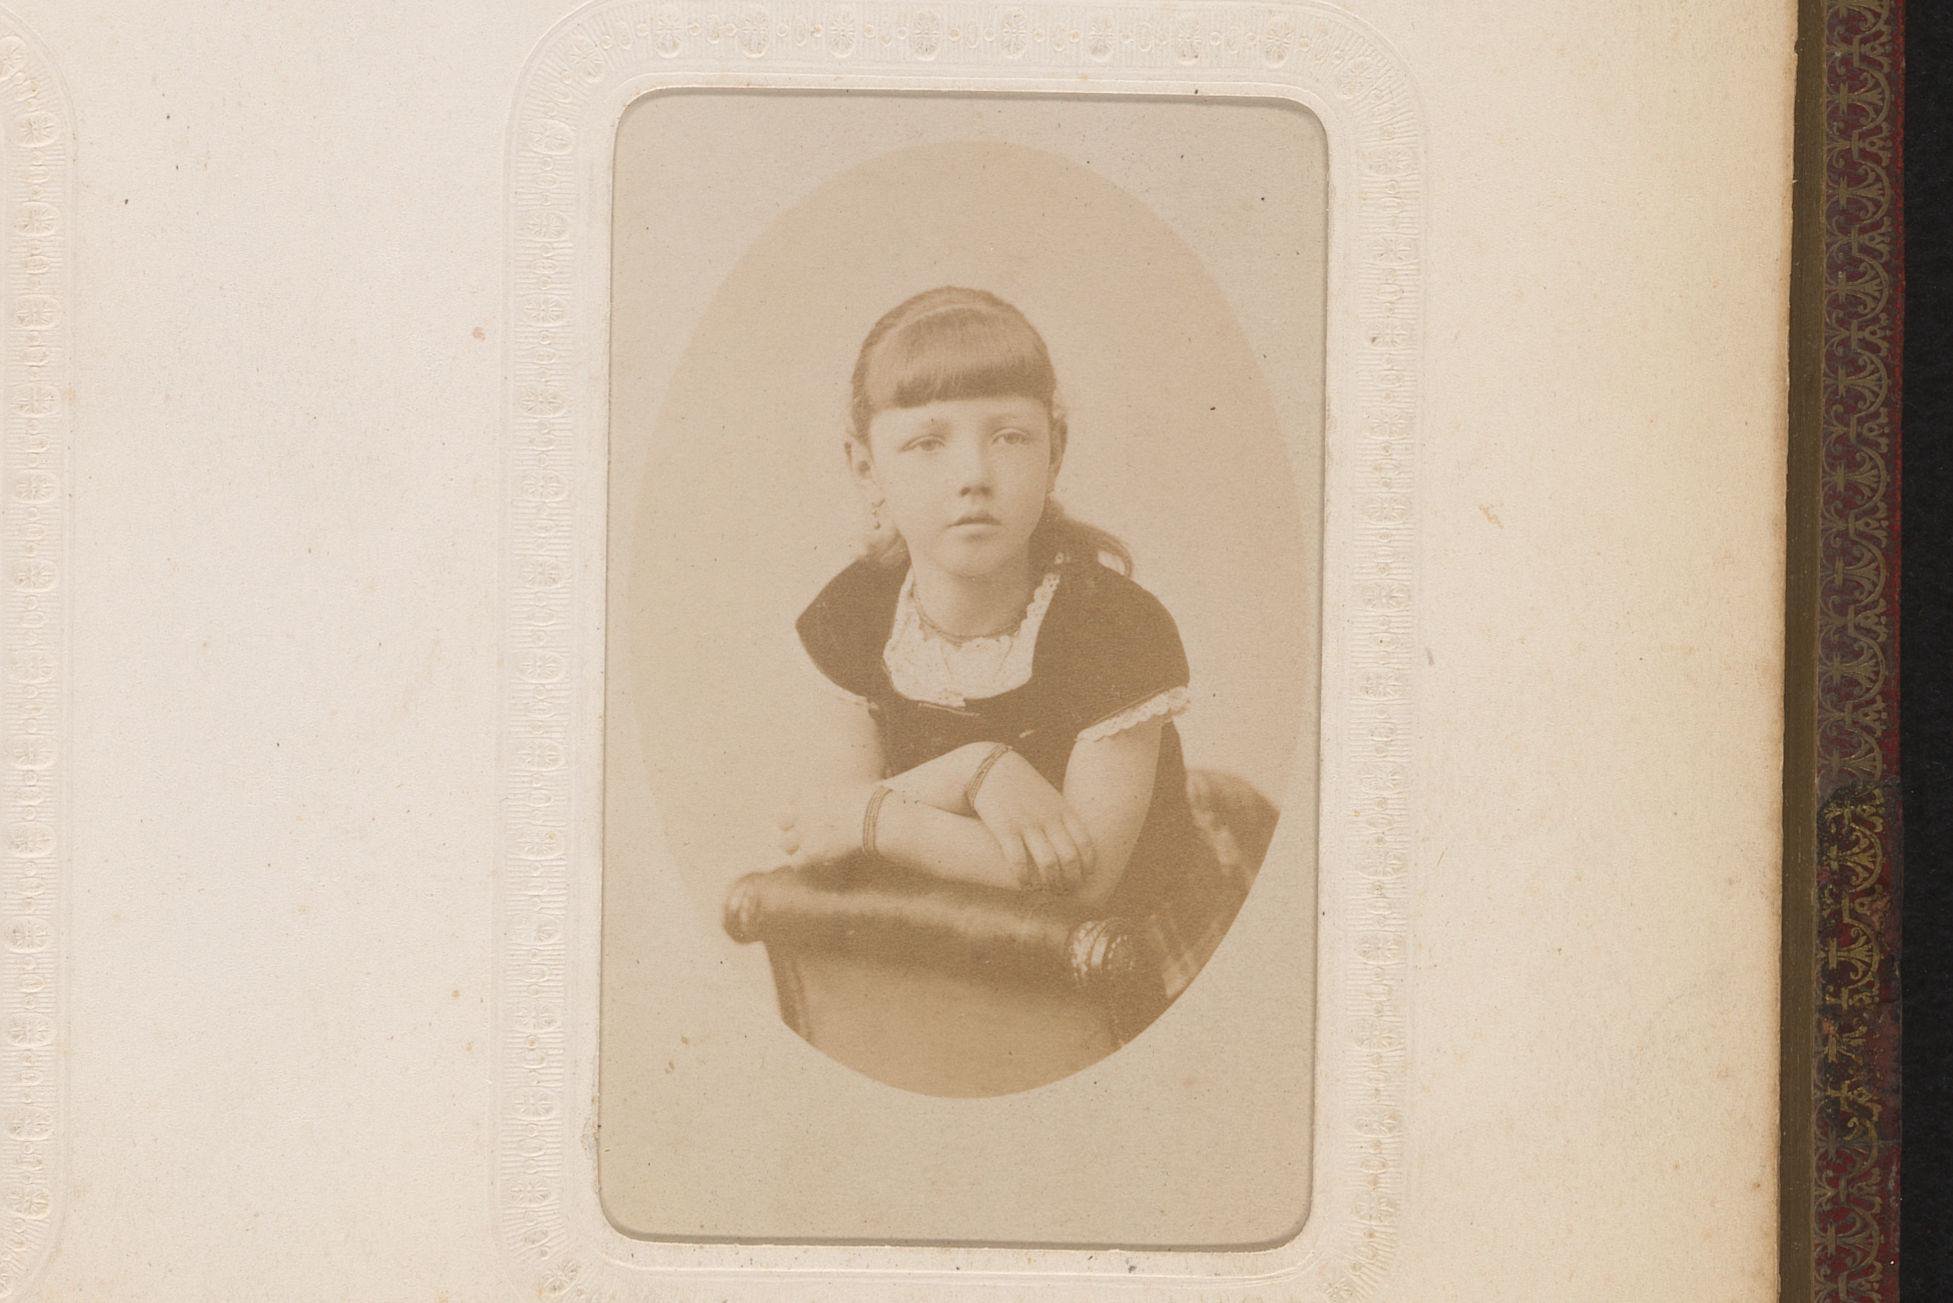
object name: album leaf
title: Portret van een meisje, knielend op een stoel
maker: Anonymous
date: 1860-1900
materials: cardboard, photographic support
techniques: albumen print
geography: netherlands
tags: kneeling figure - aa - female human figure, historical persons - bb - woman, toddler (female), chair